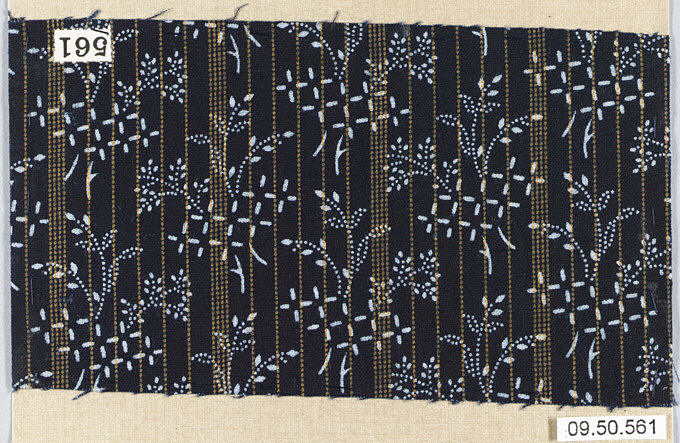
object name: piece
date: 1801-1900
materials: cotton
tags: leaves